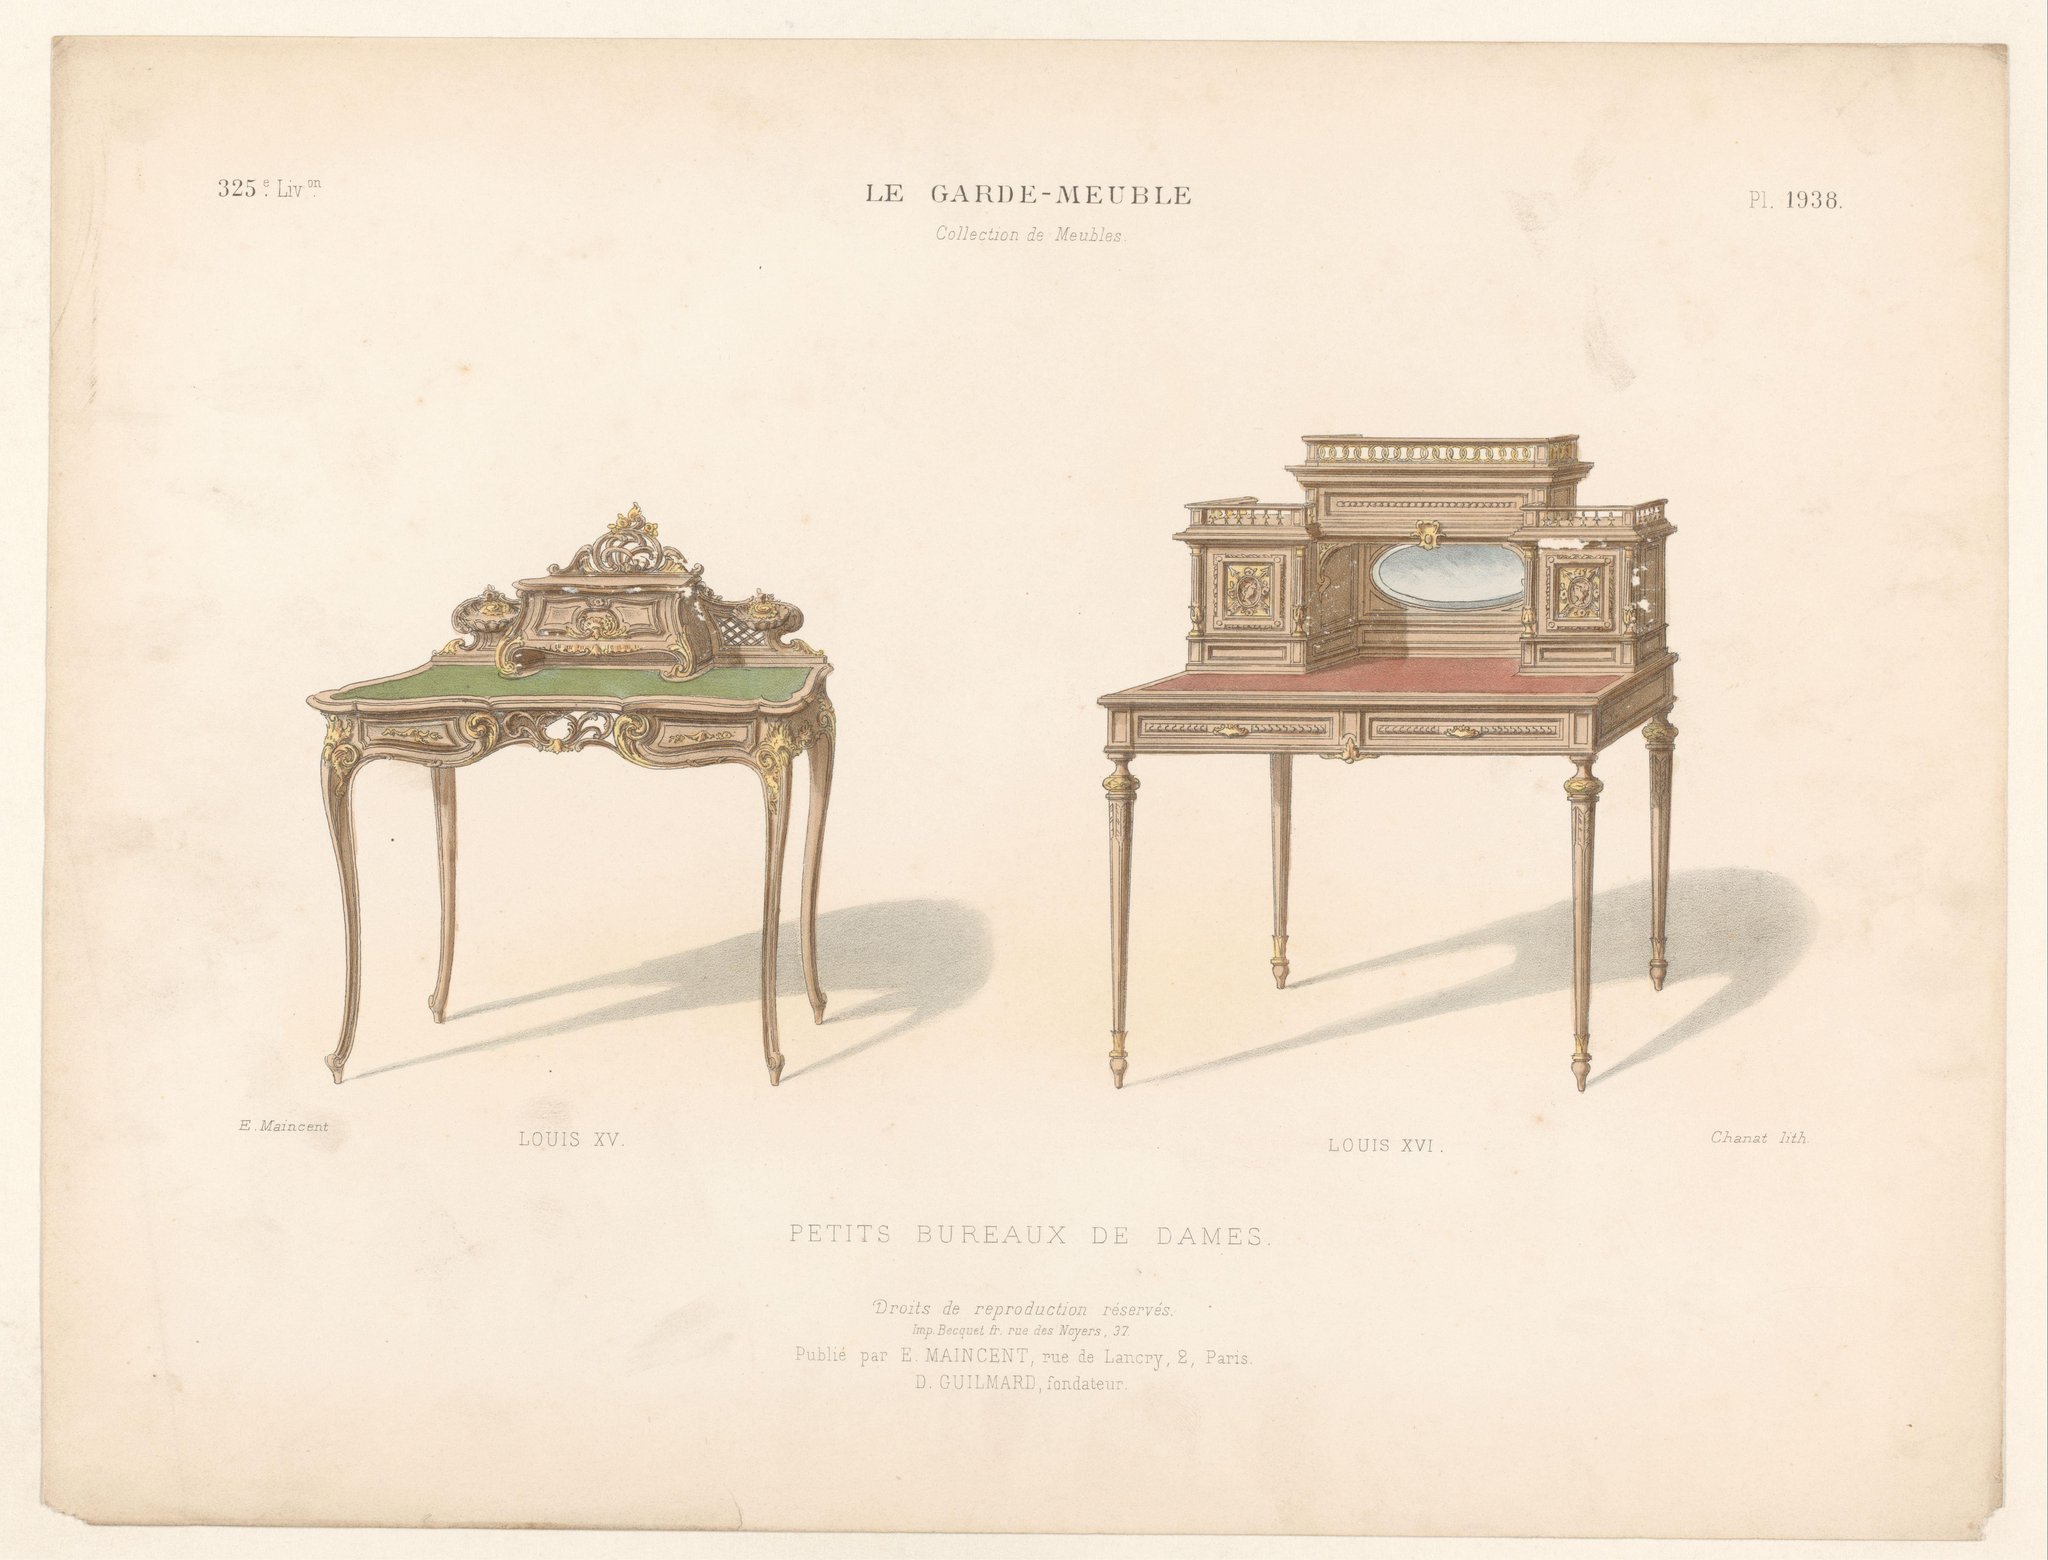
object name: print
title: Twee bureaus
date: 1885-1895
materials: paper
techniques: hand coloring, lithograph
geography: paris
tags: writing-table, writing-desk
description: Ieder Livraison in de serie Le Garde-Meuble bevat negen platen: drie 'sièges' (zitmeubels), drie 'meubles' (diverse meubels zoals tafels en kasten) en drie 'tentures' (gordijnen en draperieën).